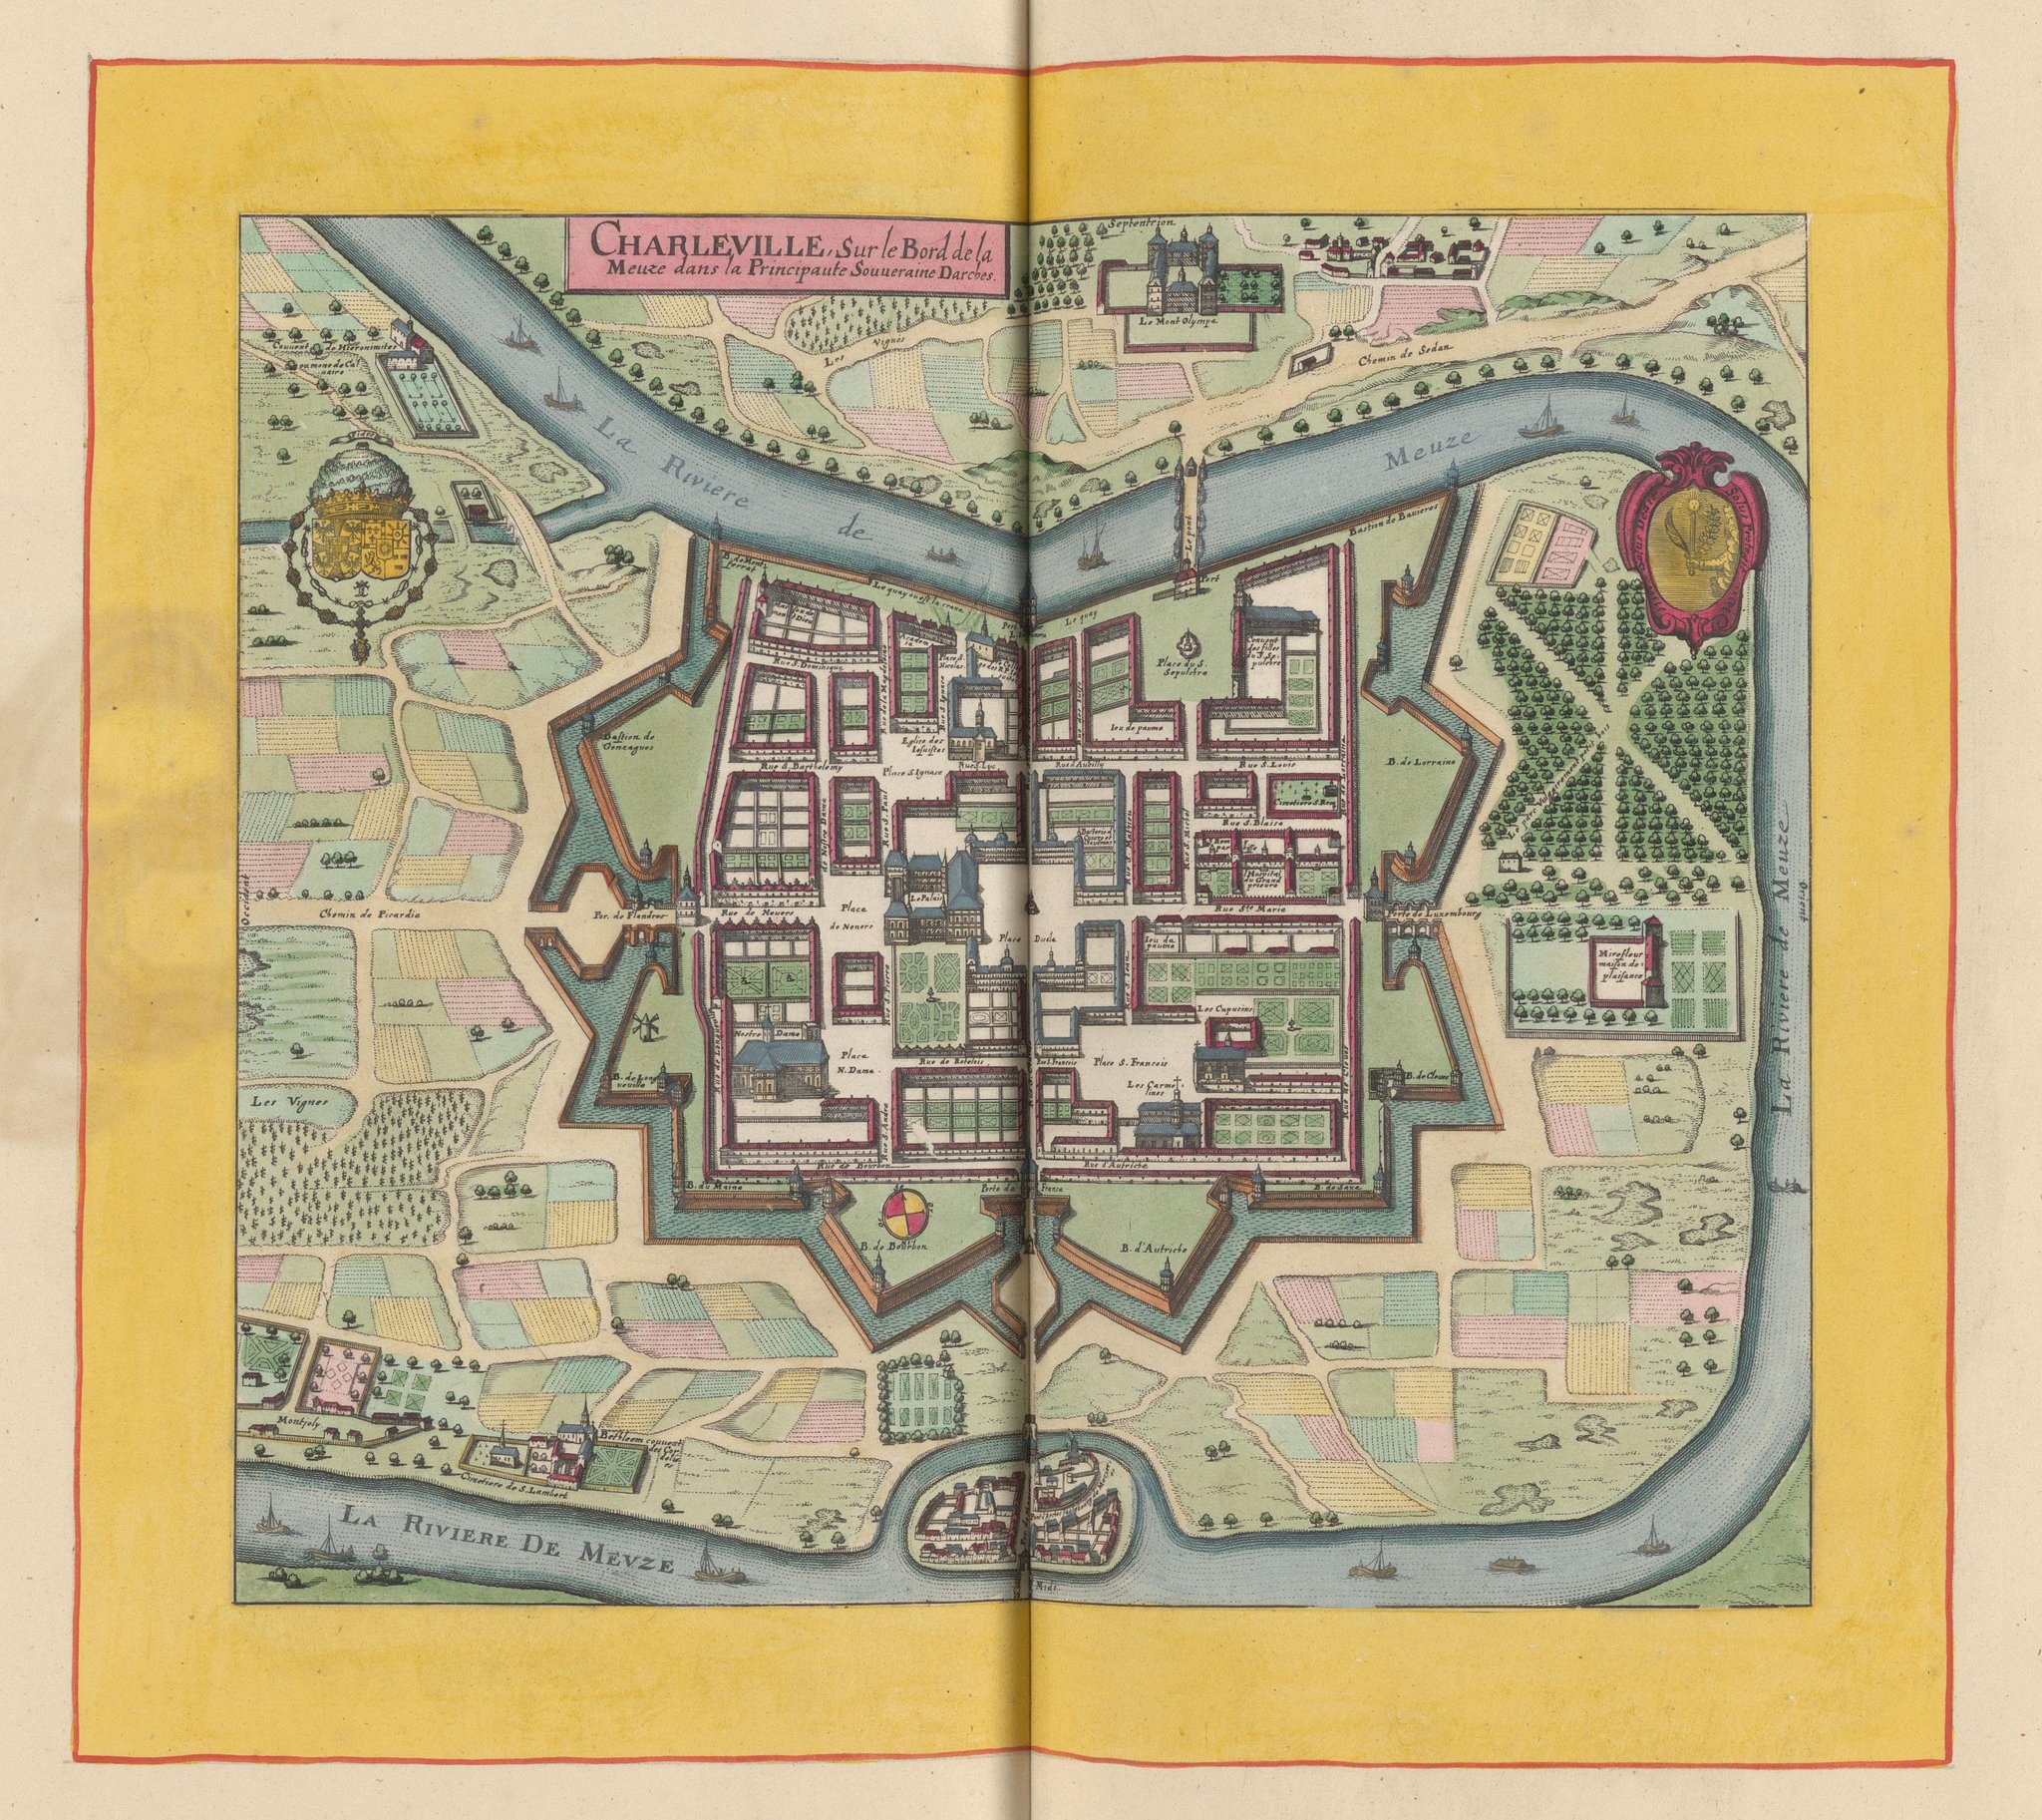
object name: area plan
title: Plattegrond van Charleville-Mézières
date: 1656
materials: paper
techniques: engraving, etching, hand coloring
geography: frankfurt am main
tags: maps of cities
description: Prent uit: Zeiller, Martin. Topographia Galliae. 13 dln. Frankfurt: Caspar Merian, 1656, dl. 3, na p. 6.